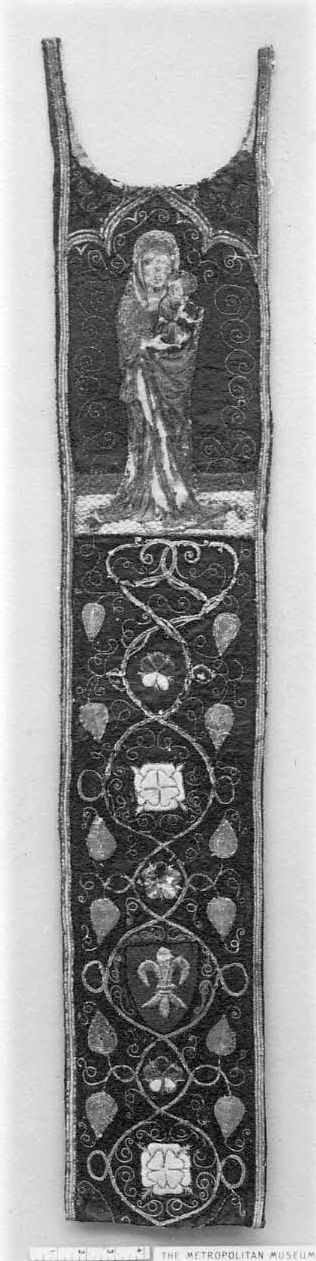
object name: orphrey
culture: french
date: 1401-1500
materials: gold thread, silk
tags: madonna and child